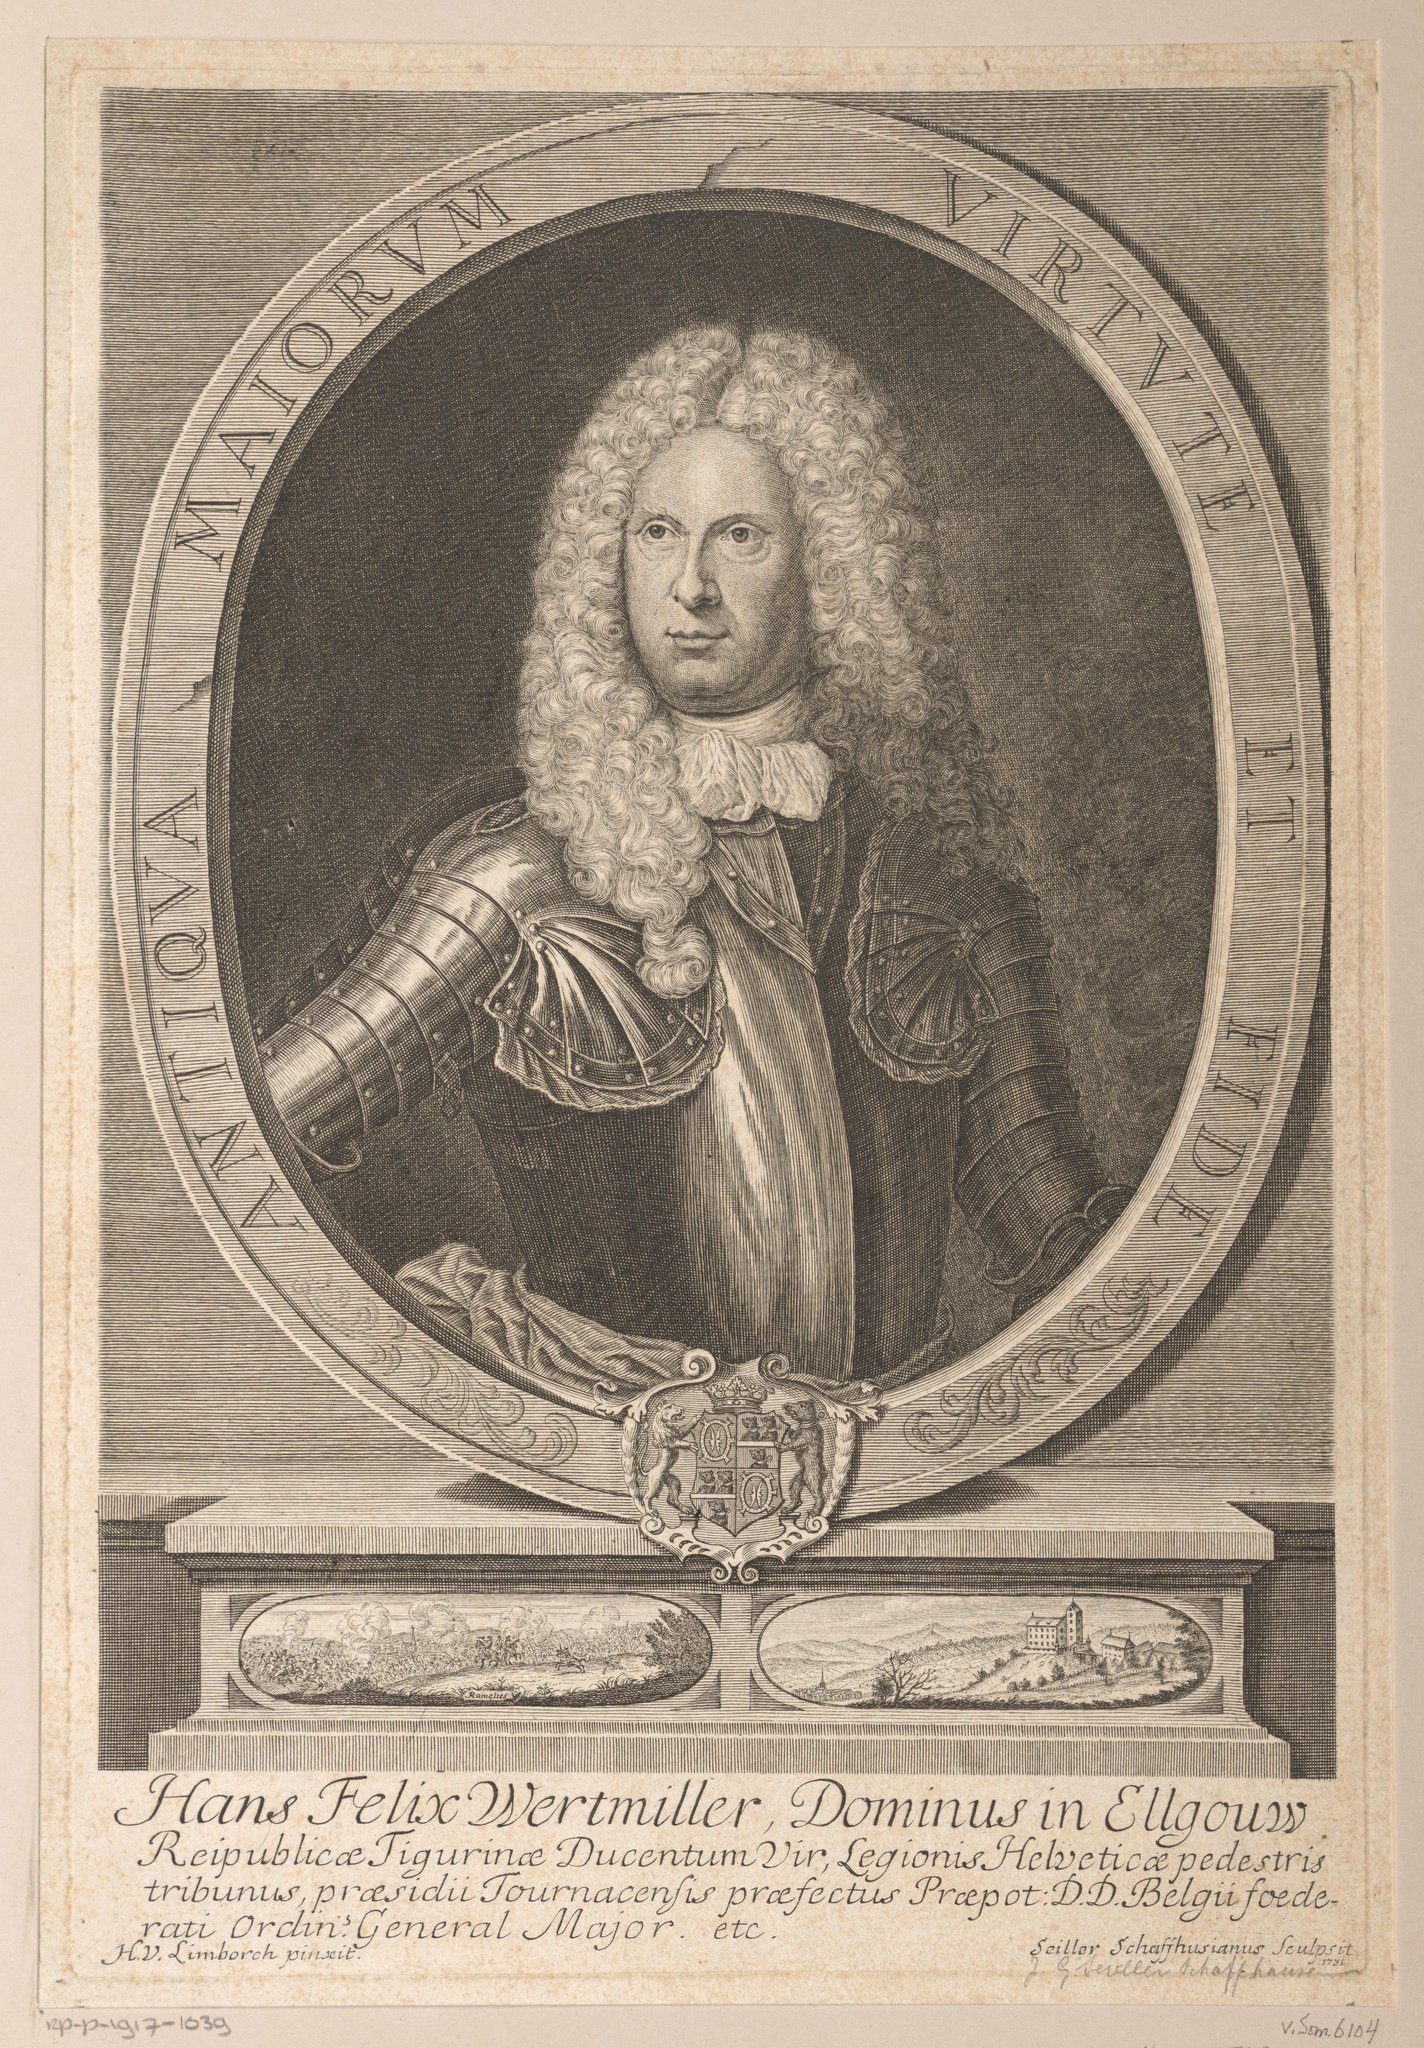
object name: print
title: Portret van Hans Felix Werdmüller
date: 1731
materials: paper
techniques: engraving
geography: schaffhausen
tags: castle, armour, historical persons, battle, armorial bearing, heraldry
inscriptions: collector's mark: Lugt 2228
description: Met vierregelig onderschrift in het Latijn.